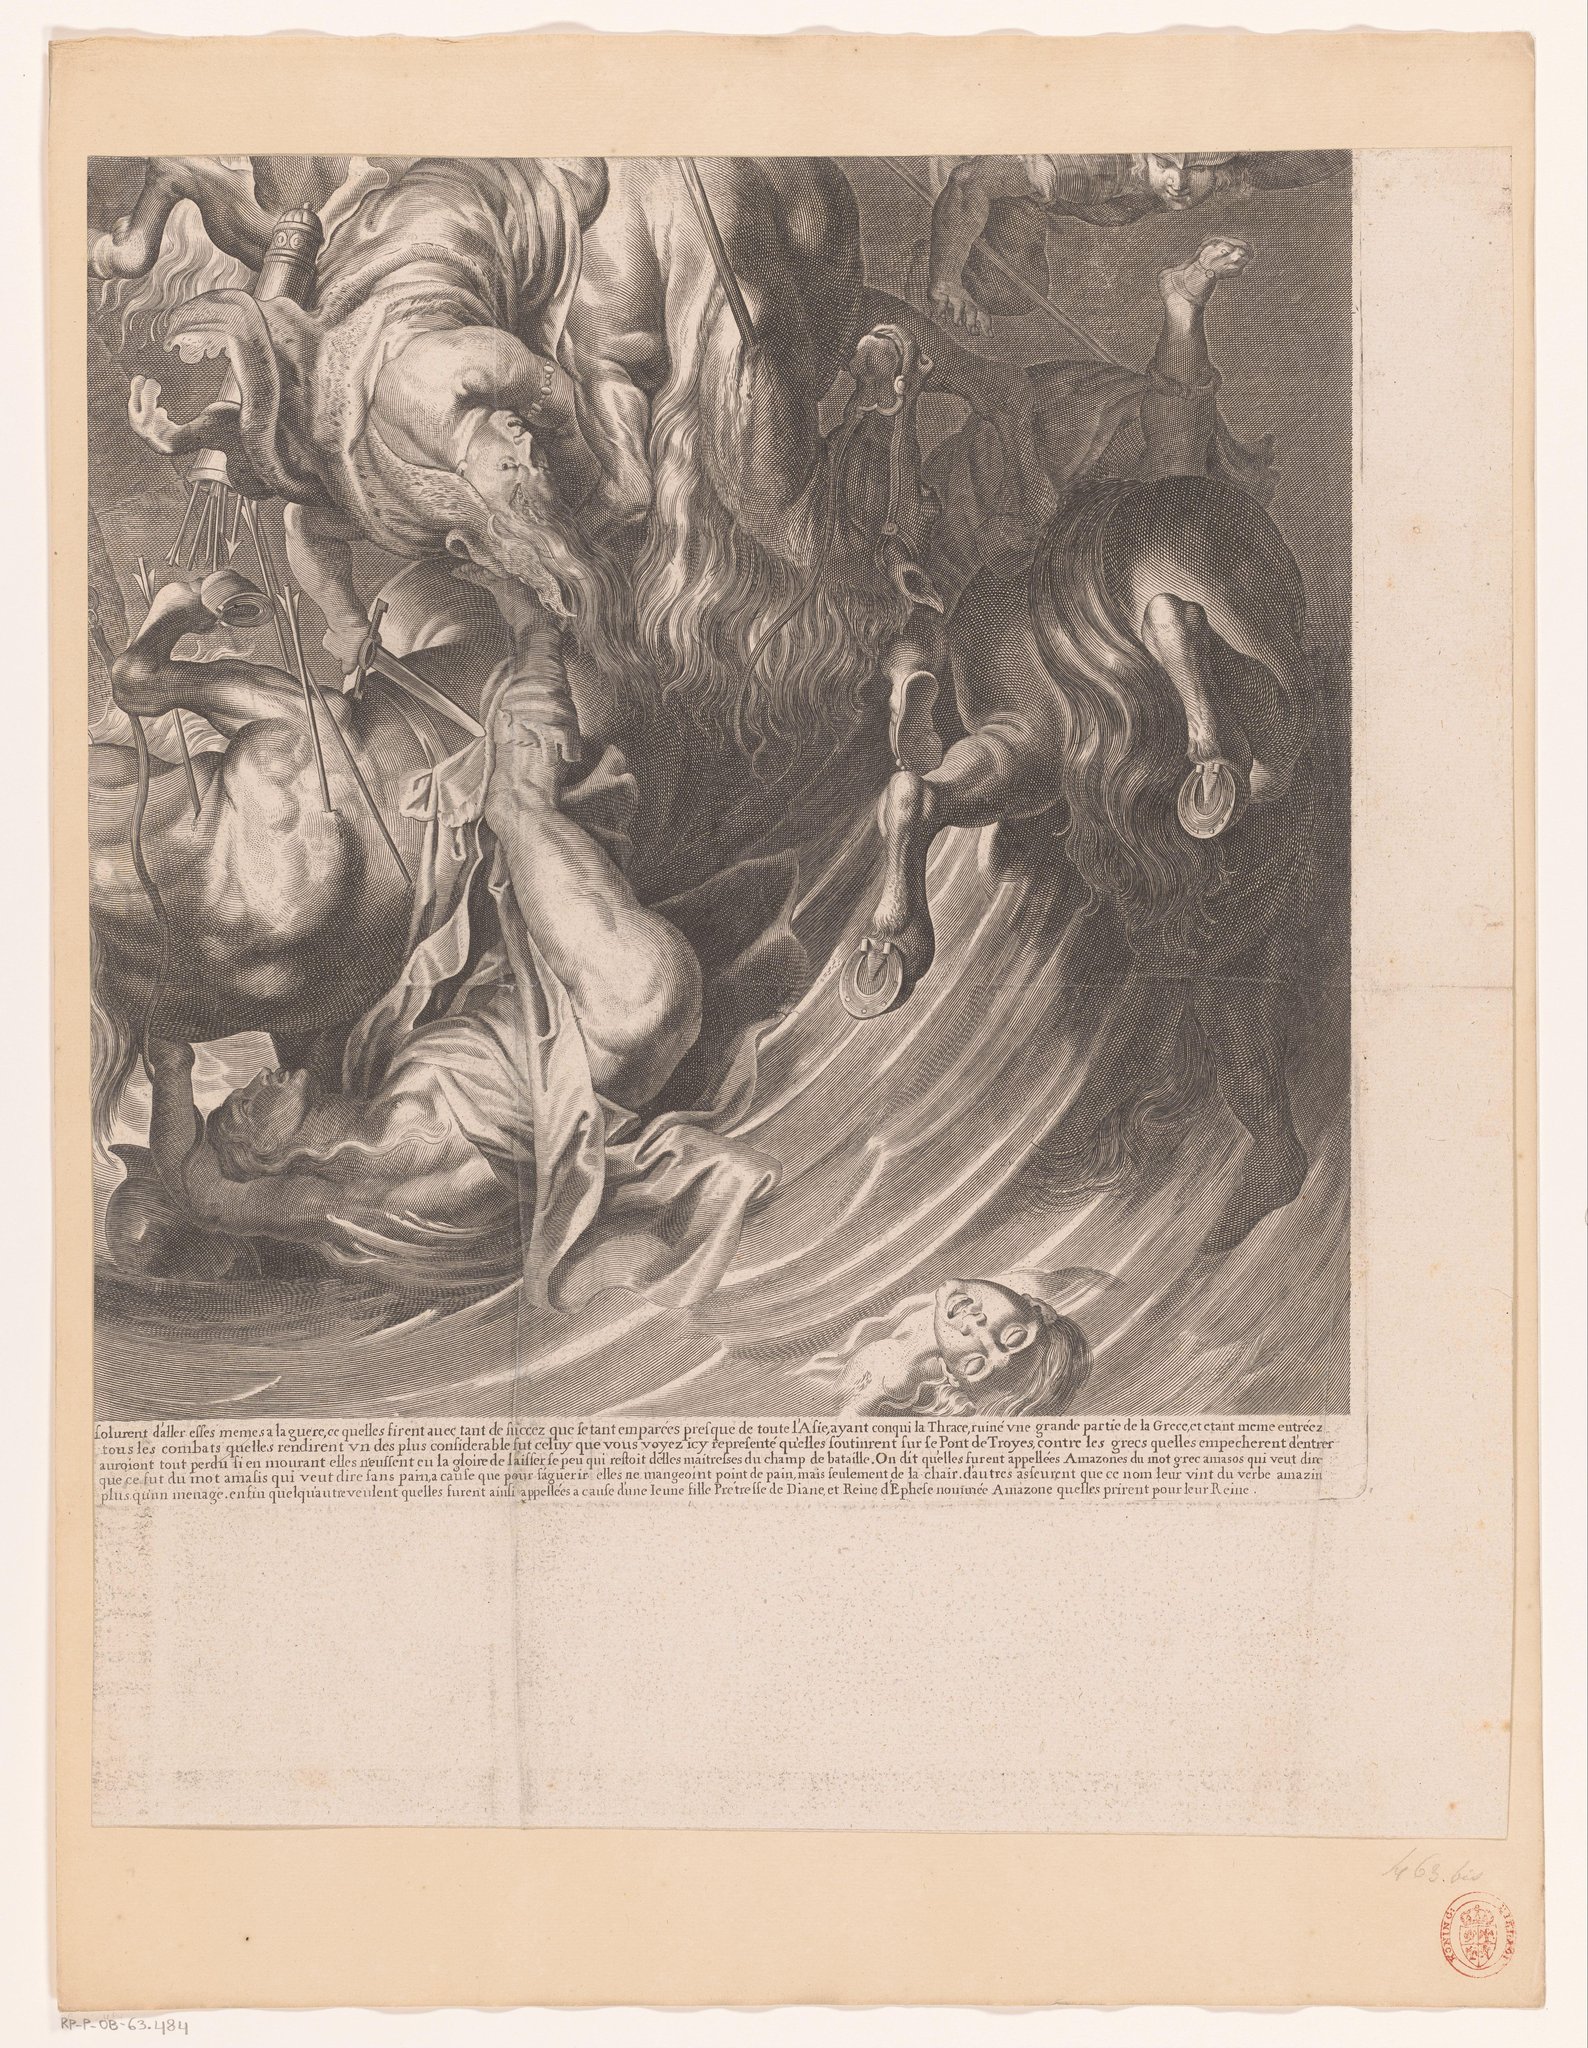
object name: print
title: Gevecht tussen Amazones en Grieken (deel rechtsonder)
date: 1648-1670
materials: paper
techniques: engraving, etching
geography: paris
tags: battle of amazons; amazonomachy, bridge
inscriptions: collector's mark: Lugt 240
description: Gevecht tussen Amazones en Grieken op de brug van Troje.